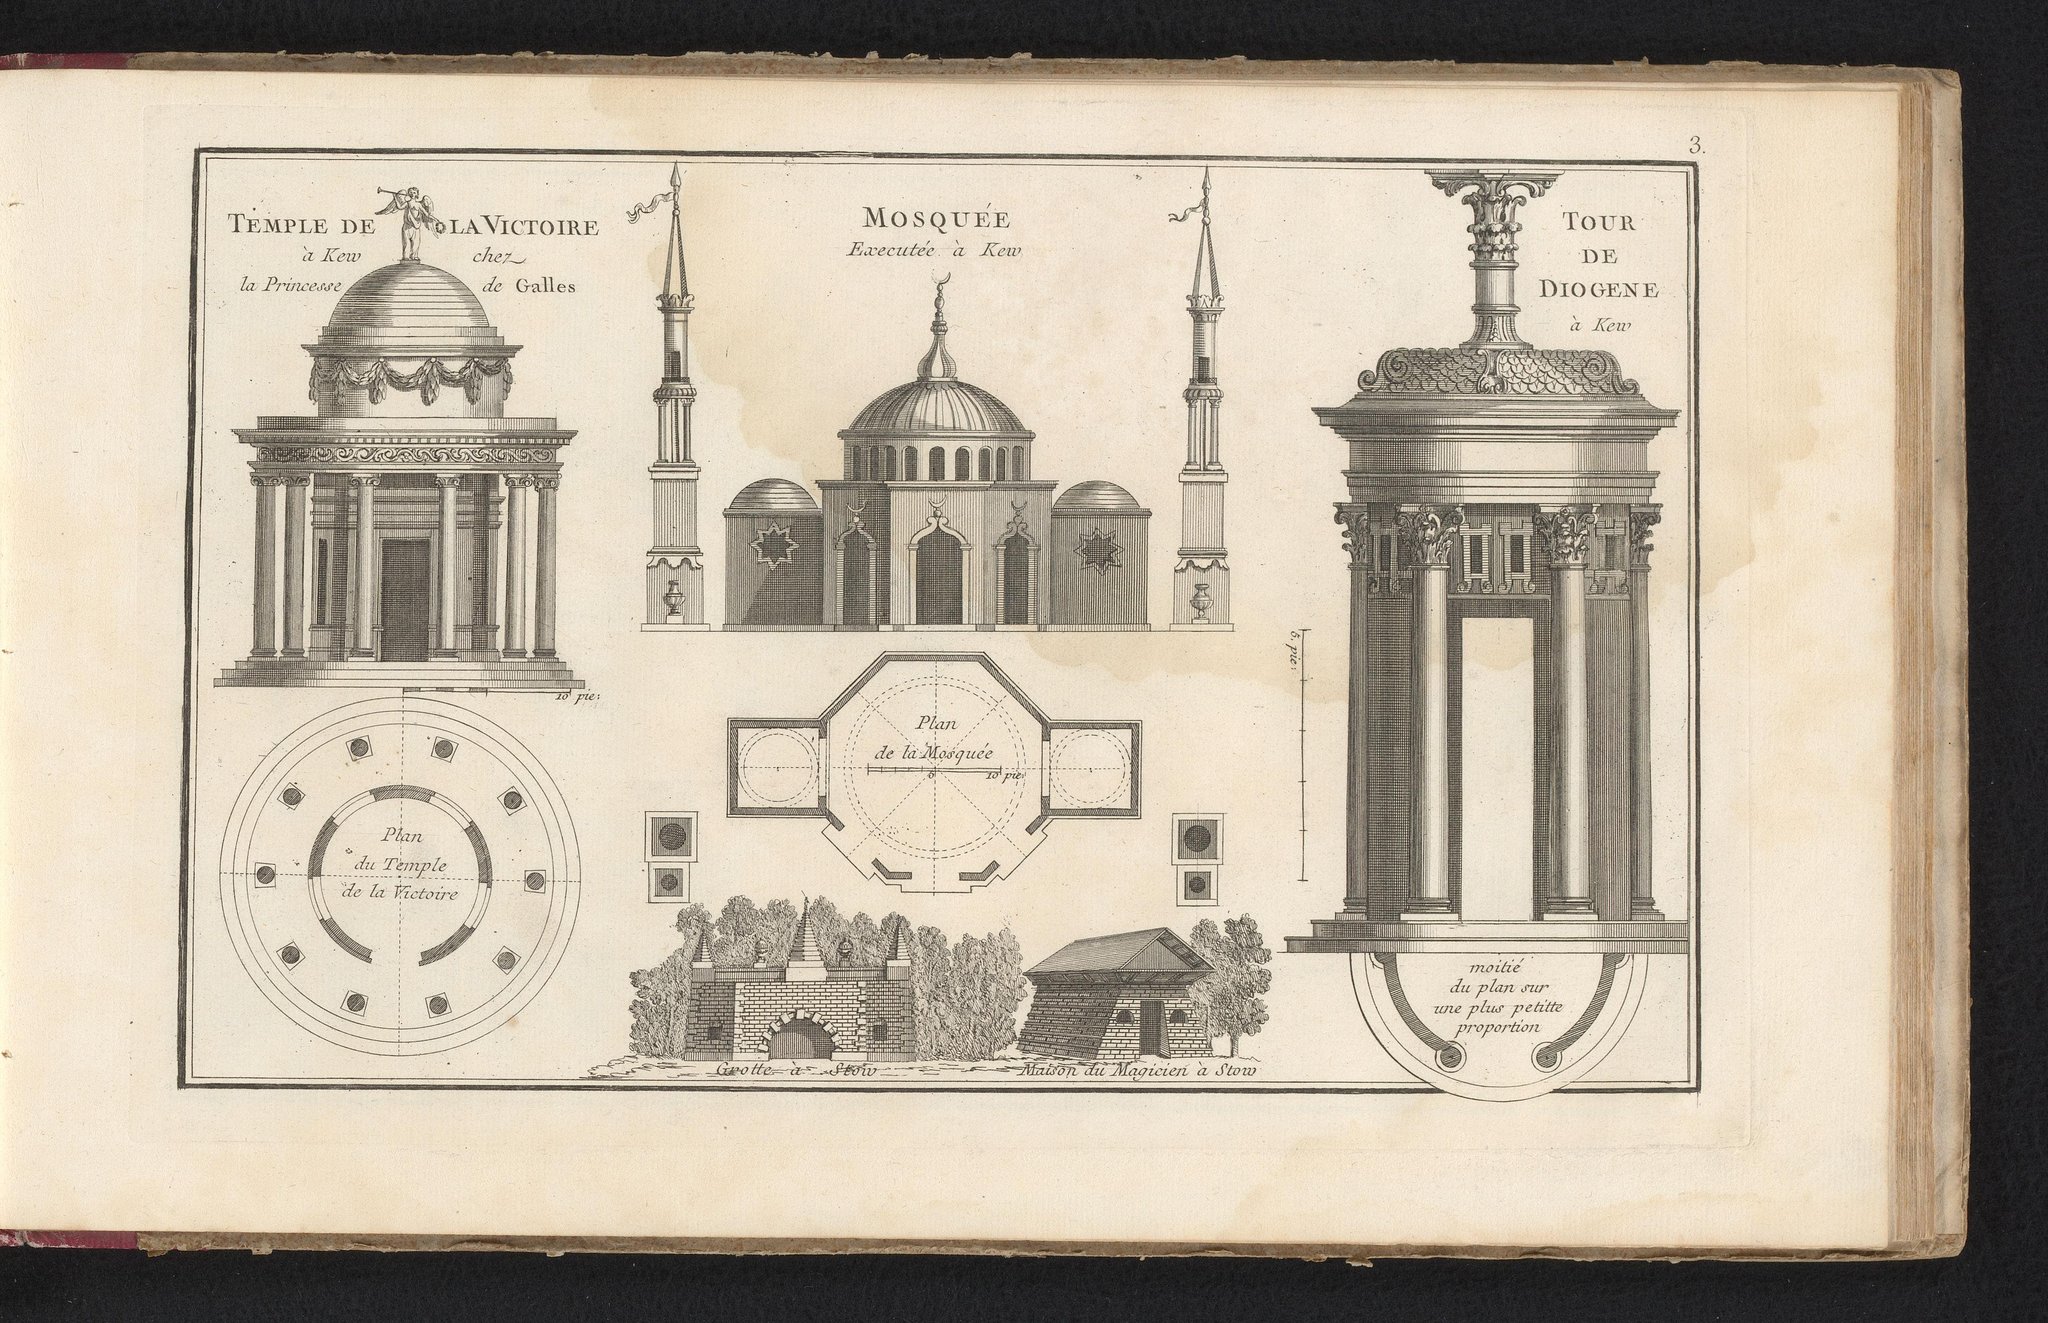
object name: print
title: Landschapstuinen in Chinees-Engelse stijl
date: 1775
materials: paper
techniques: engraving, etching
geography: paris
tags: garden buildings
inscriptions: collector's mark: Lugt 2760, collector's mark: Lugt 2228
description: De serie 'Jardins anglo-chinois à la mode' verscheen in totaal in 21 zogeheten 'cahiers' (afleveringen). De huidige prent komt uit het tweede 'cahier'. Het Rijksmuseum Amsterdam bezit drie banden met daarin in totaal zes 'cahiers' van deze reeks. In de documentatie wordt verwezen naar een in de bibliotheek van het Rijksmuseum Amsterdam aanwezige facsimile van het complete werk.